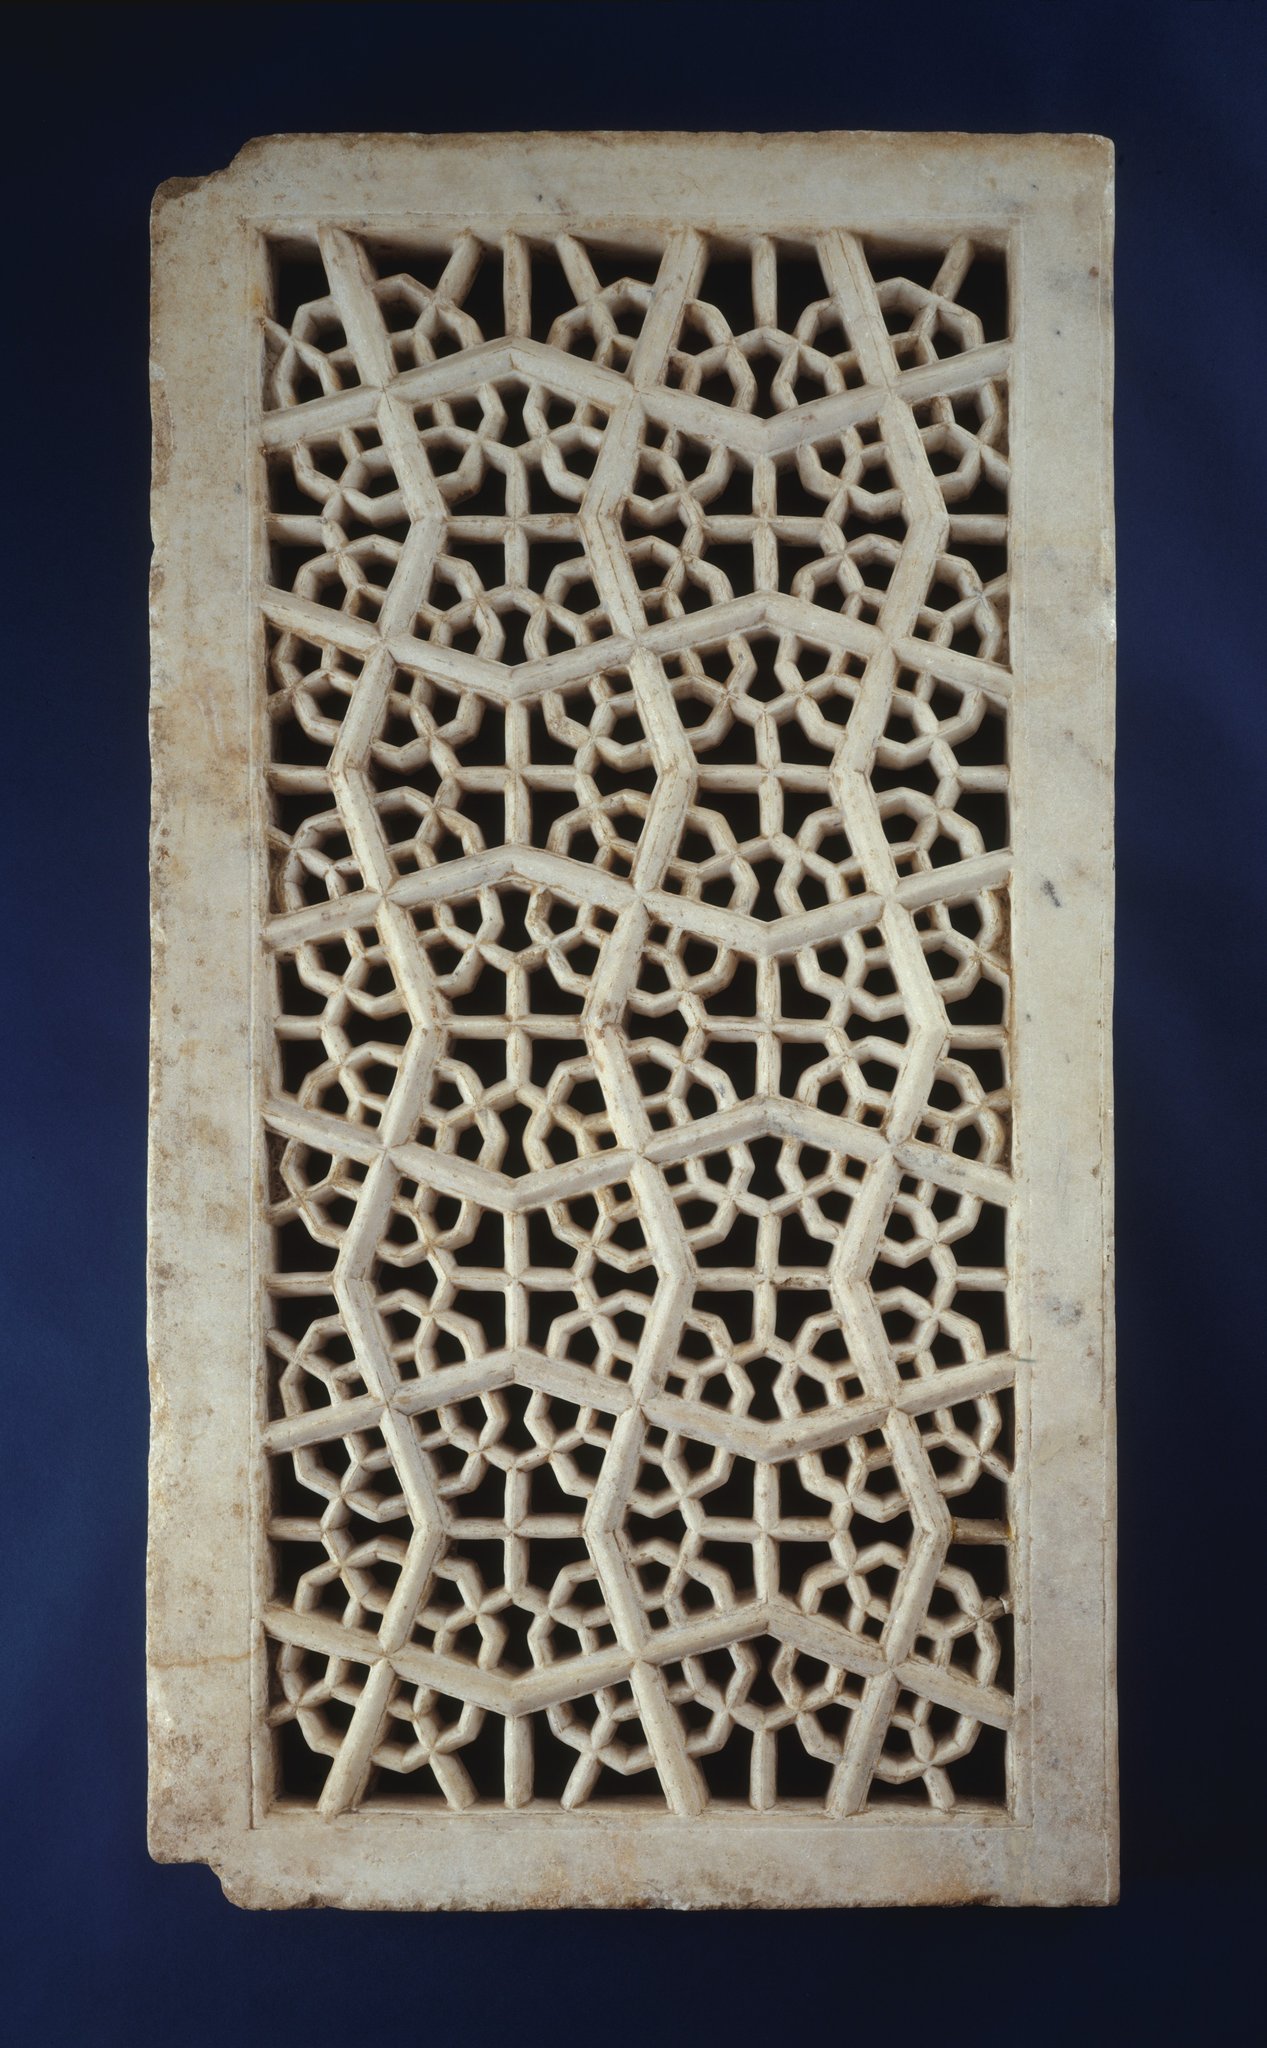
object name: screen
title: Pierced Window Screen (Jali)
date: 1601-1633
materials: marble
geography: india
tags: screens